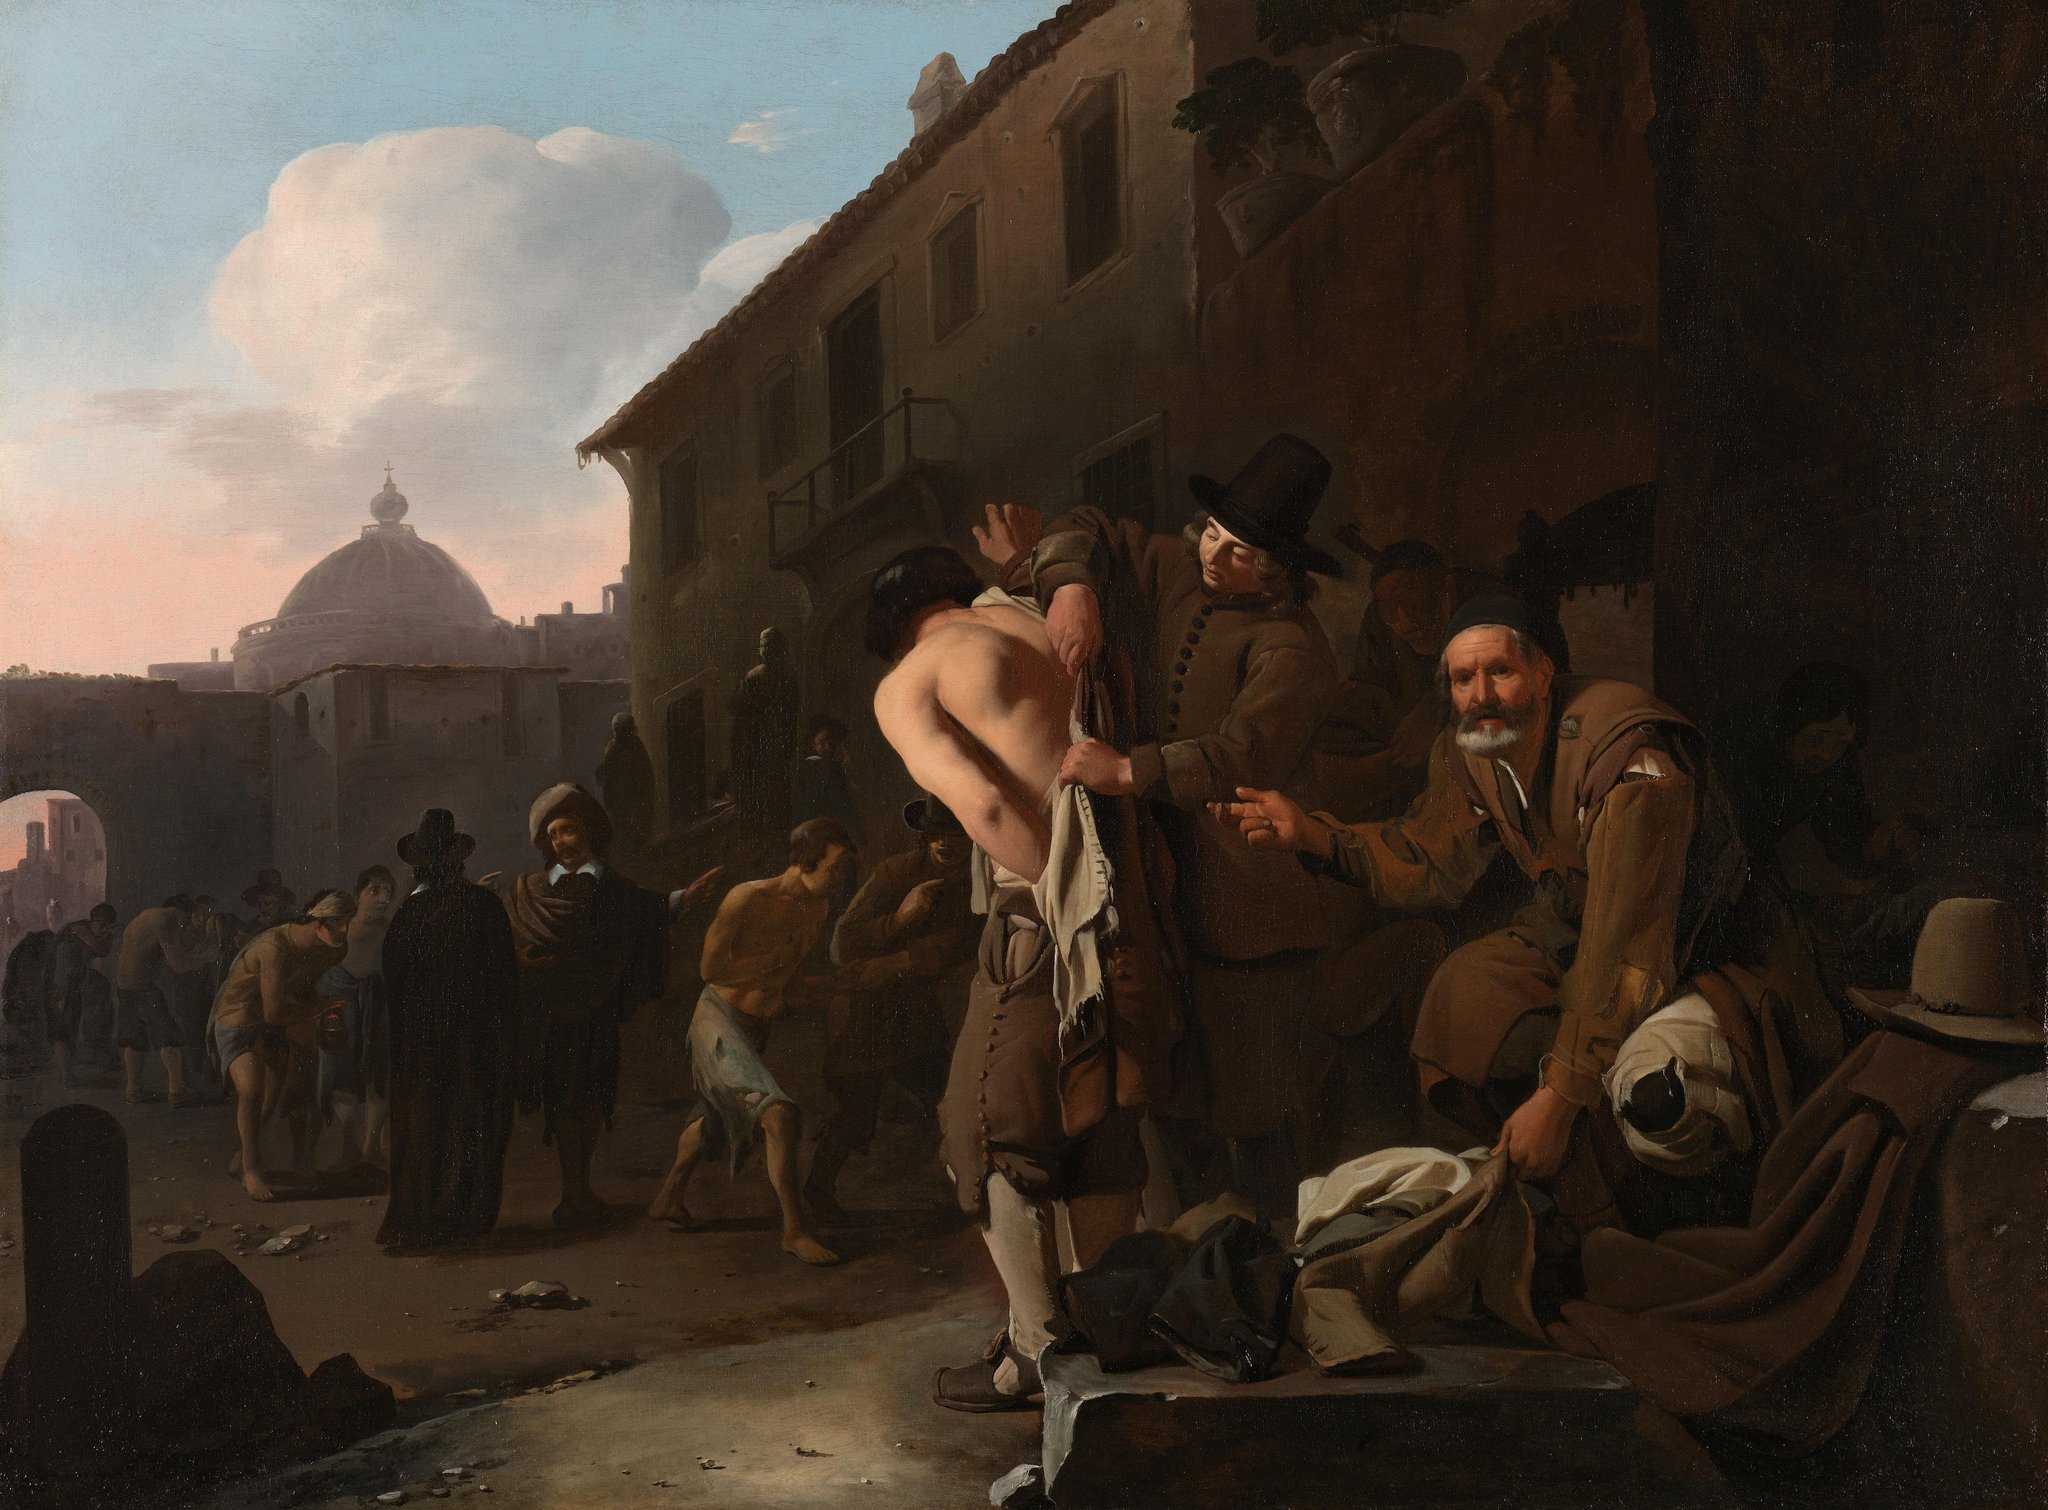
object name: painting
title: Clothing the Naked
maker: michael sweerts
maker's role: painter, print maker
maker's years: 1618-1664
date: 1646-1649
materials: canvas, oil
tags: clothing the naked, 'nudus vestitur' ~ one of the (seven) acts of mercy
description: By having one of the figures look out of the painting at the viewer, Sweerts enhances the poignancy of ‘clothing the naked’. The brightly lit shoulder of the man at the centre of the composition emphasizes his nakedness, giving the painting a sense of immediacy.